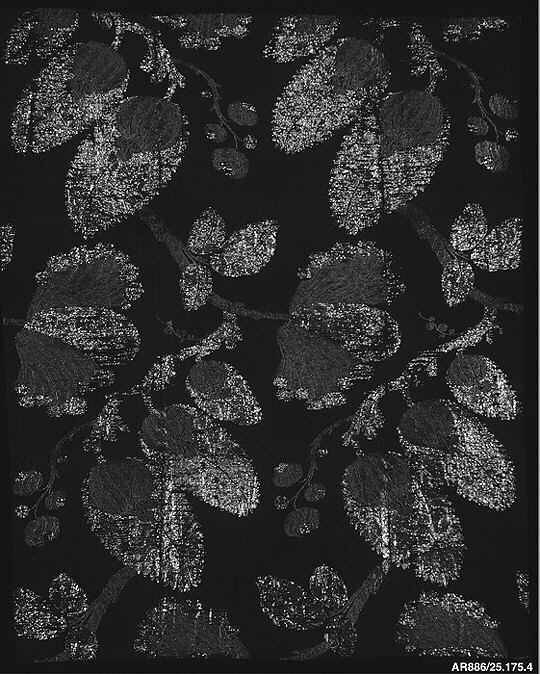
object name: veil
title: Veil (Aër)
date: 1761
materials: metal thread, silk